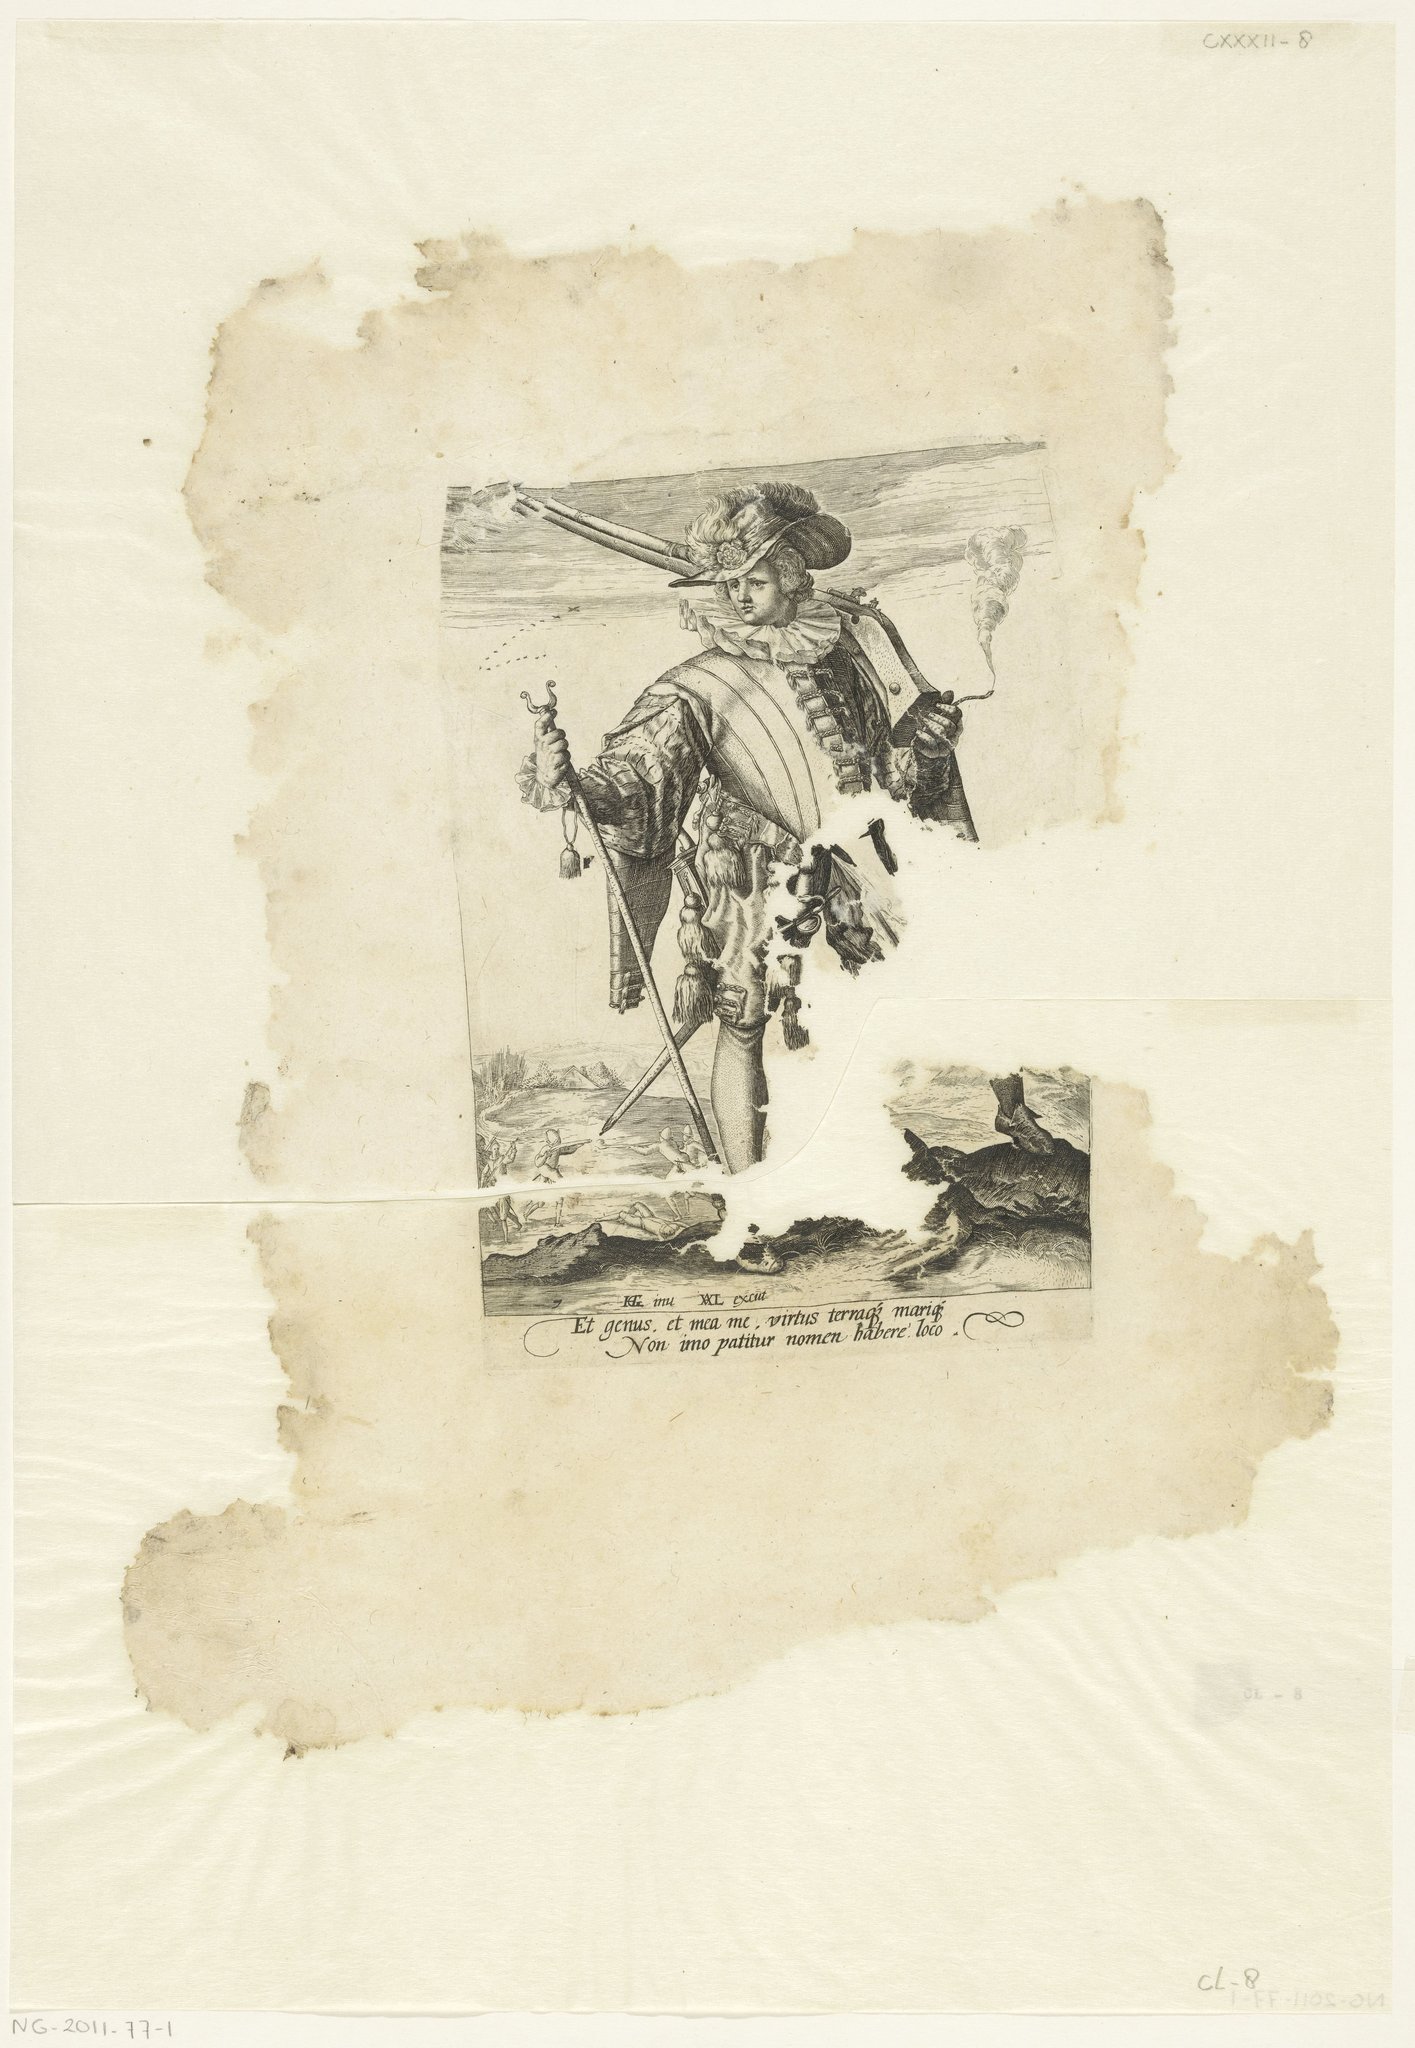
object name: print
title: Musketier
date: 1587-1596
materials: paper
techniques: engraving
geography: northern netherlands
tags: private soldier, firearms: rifle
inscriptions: watermark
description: De prenten in de Nova Zembla collectie zijn tijdens een expeditie van Willem Barendsz en Jacob van Heemskerk in 1596-1597 noodgedwongen in het winterkamp, het ‘Behouden Huis’, op het eiland achtergelaten. De prenten waren in één of meerdere stapels als handelswaar meegenomen vanuit Amsterdam. Bijna drie eeuwen later, in 1871, keerde de Noor Elling Carlsen terug naar Nova Zembla en vond daar de restanten van het ‘Behouden Huis, inclusief een groot deel van de inventaris. Een deel van de prenten, in de vorm van aaneengekoekte kluiten, werd toen ook teruggevonden. De papierkluiten waren soms op meerdere plekken gebroken. Tussen 1975-1979 zijn de prenten van elkaar gescheiden. Dit leverde in totaal ca. 1000 fragmenten van ca. 400 afdrukken van ca. 150 verschillende prenten op. Voor zover mogelijk zijn de fragmenten samengevoegd en zijn de prenten gereconstrueerd.